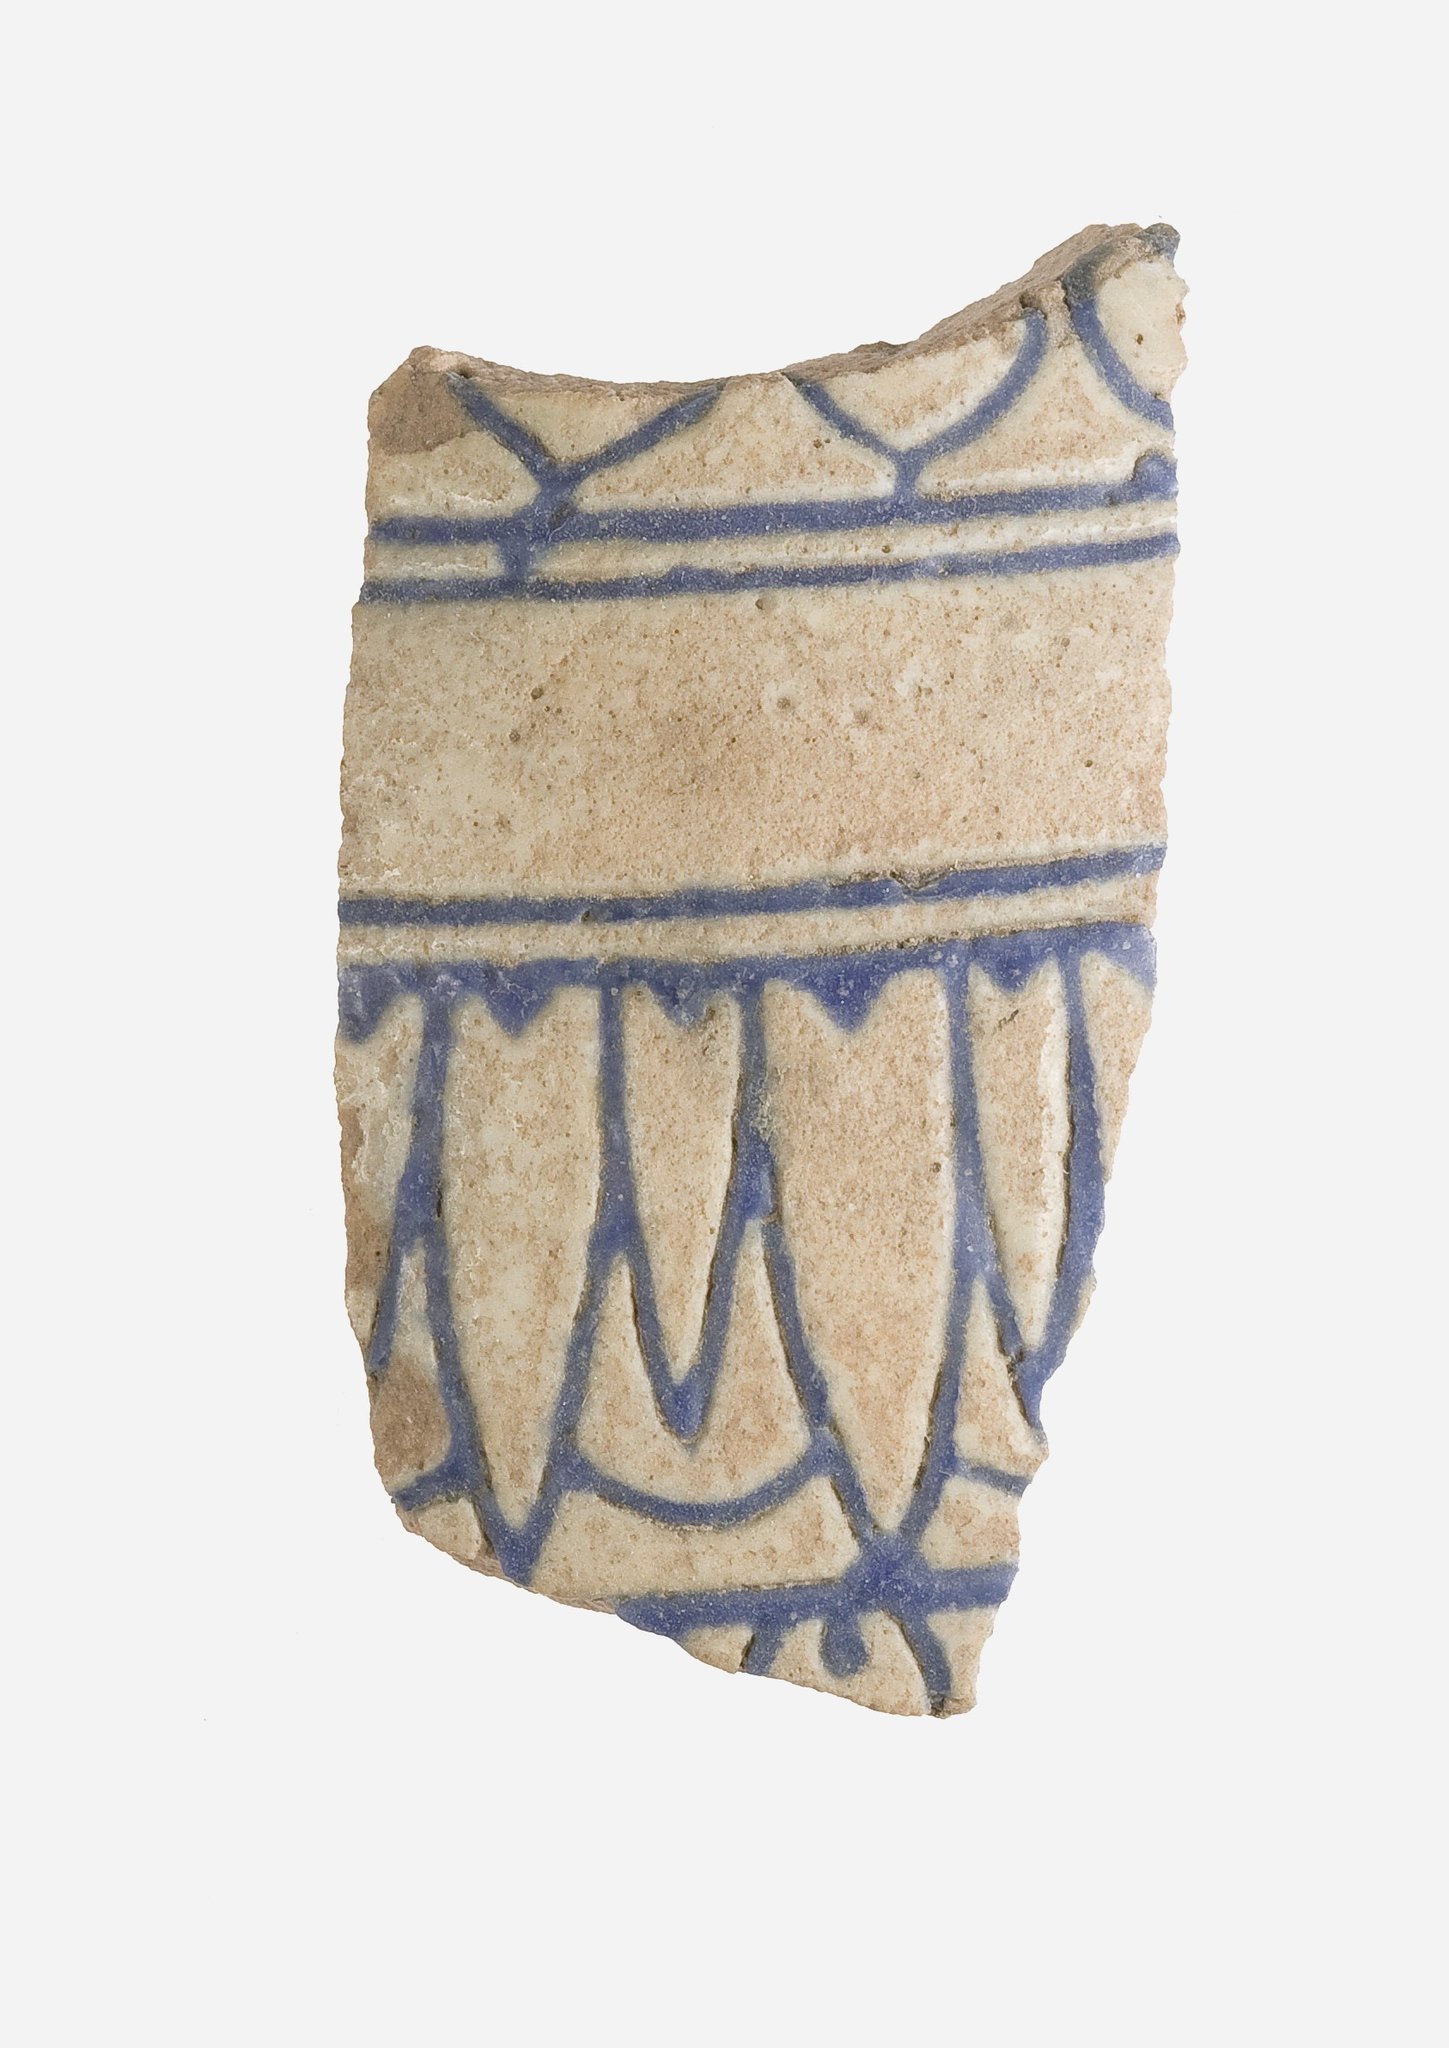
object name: vase fragment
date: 1390-1352 BCE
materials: faience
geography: egypt